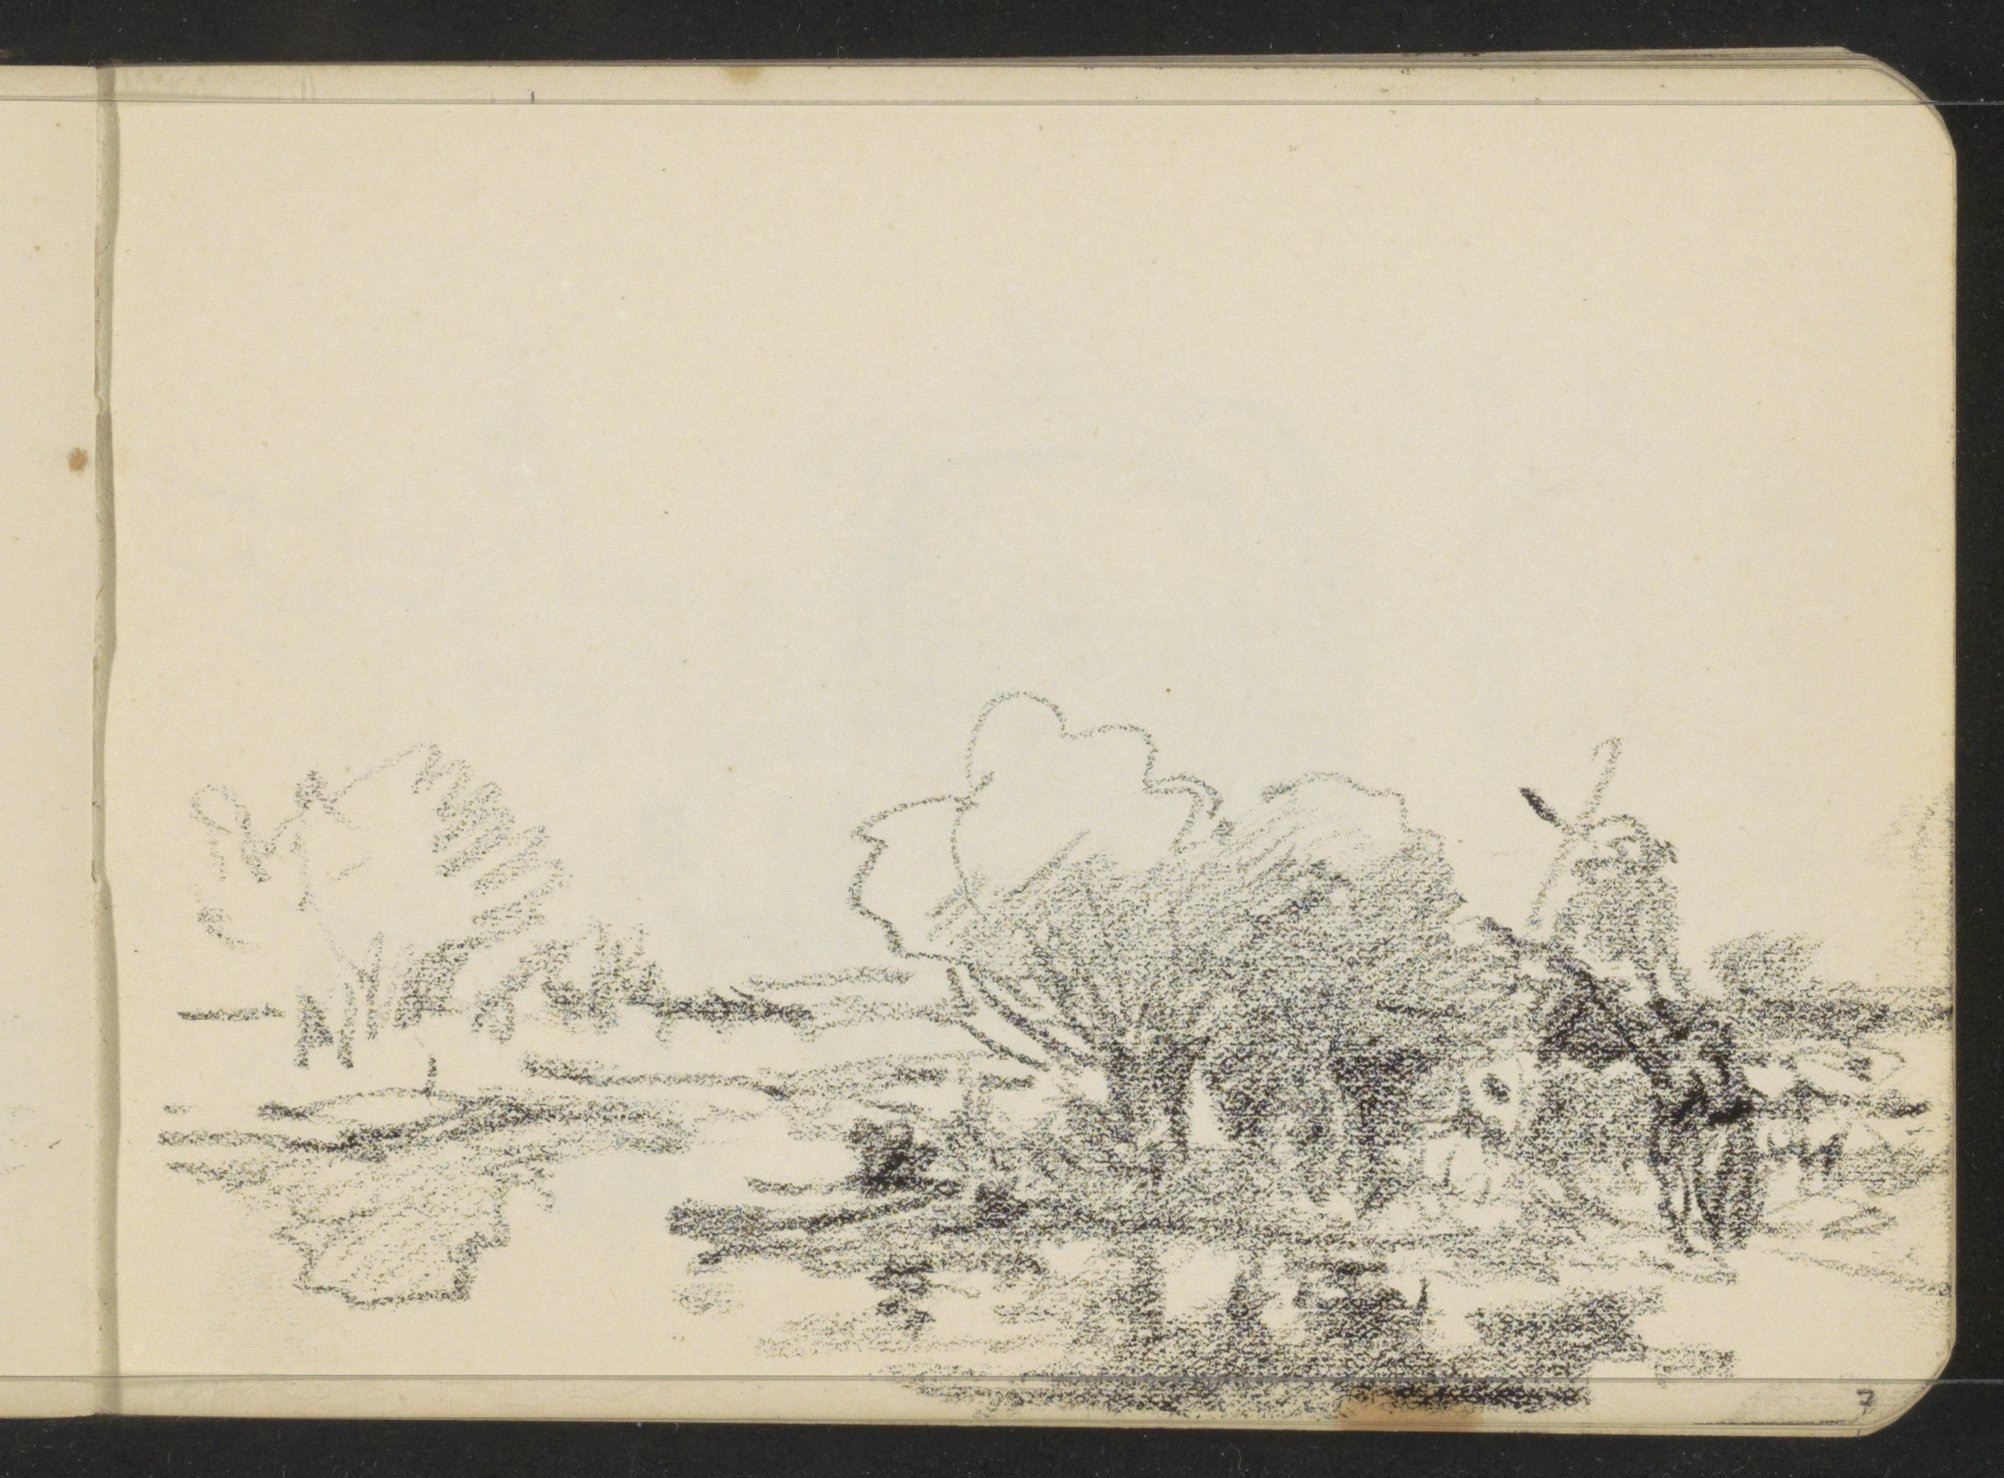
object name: sketchbook leaf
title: Landschap met water en een molen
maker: willem cornelis rip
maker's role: draughtsman, painter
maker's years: 1856-1922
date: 1914-1916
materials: chalk, paper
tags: landscapes with waters, waterscapes, seascapes (in the temperate zone), windmill in landscape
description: Blad 7 recto uit een schetsboek met 41 bladen.